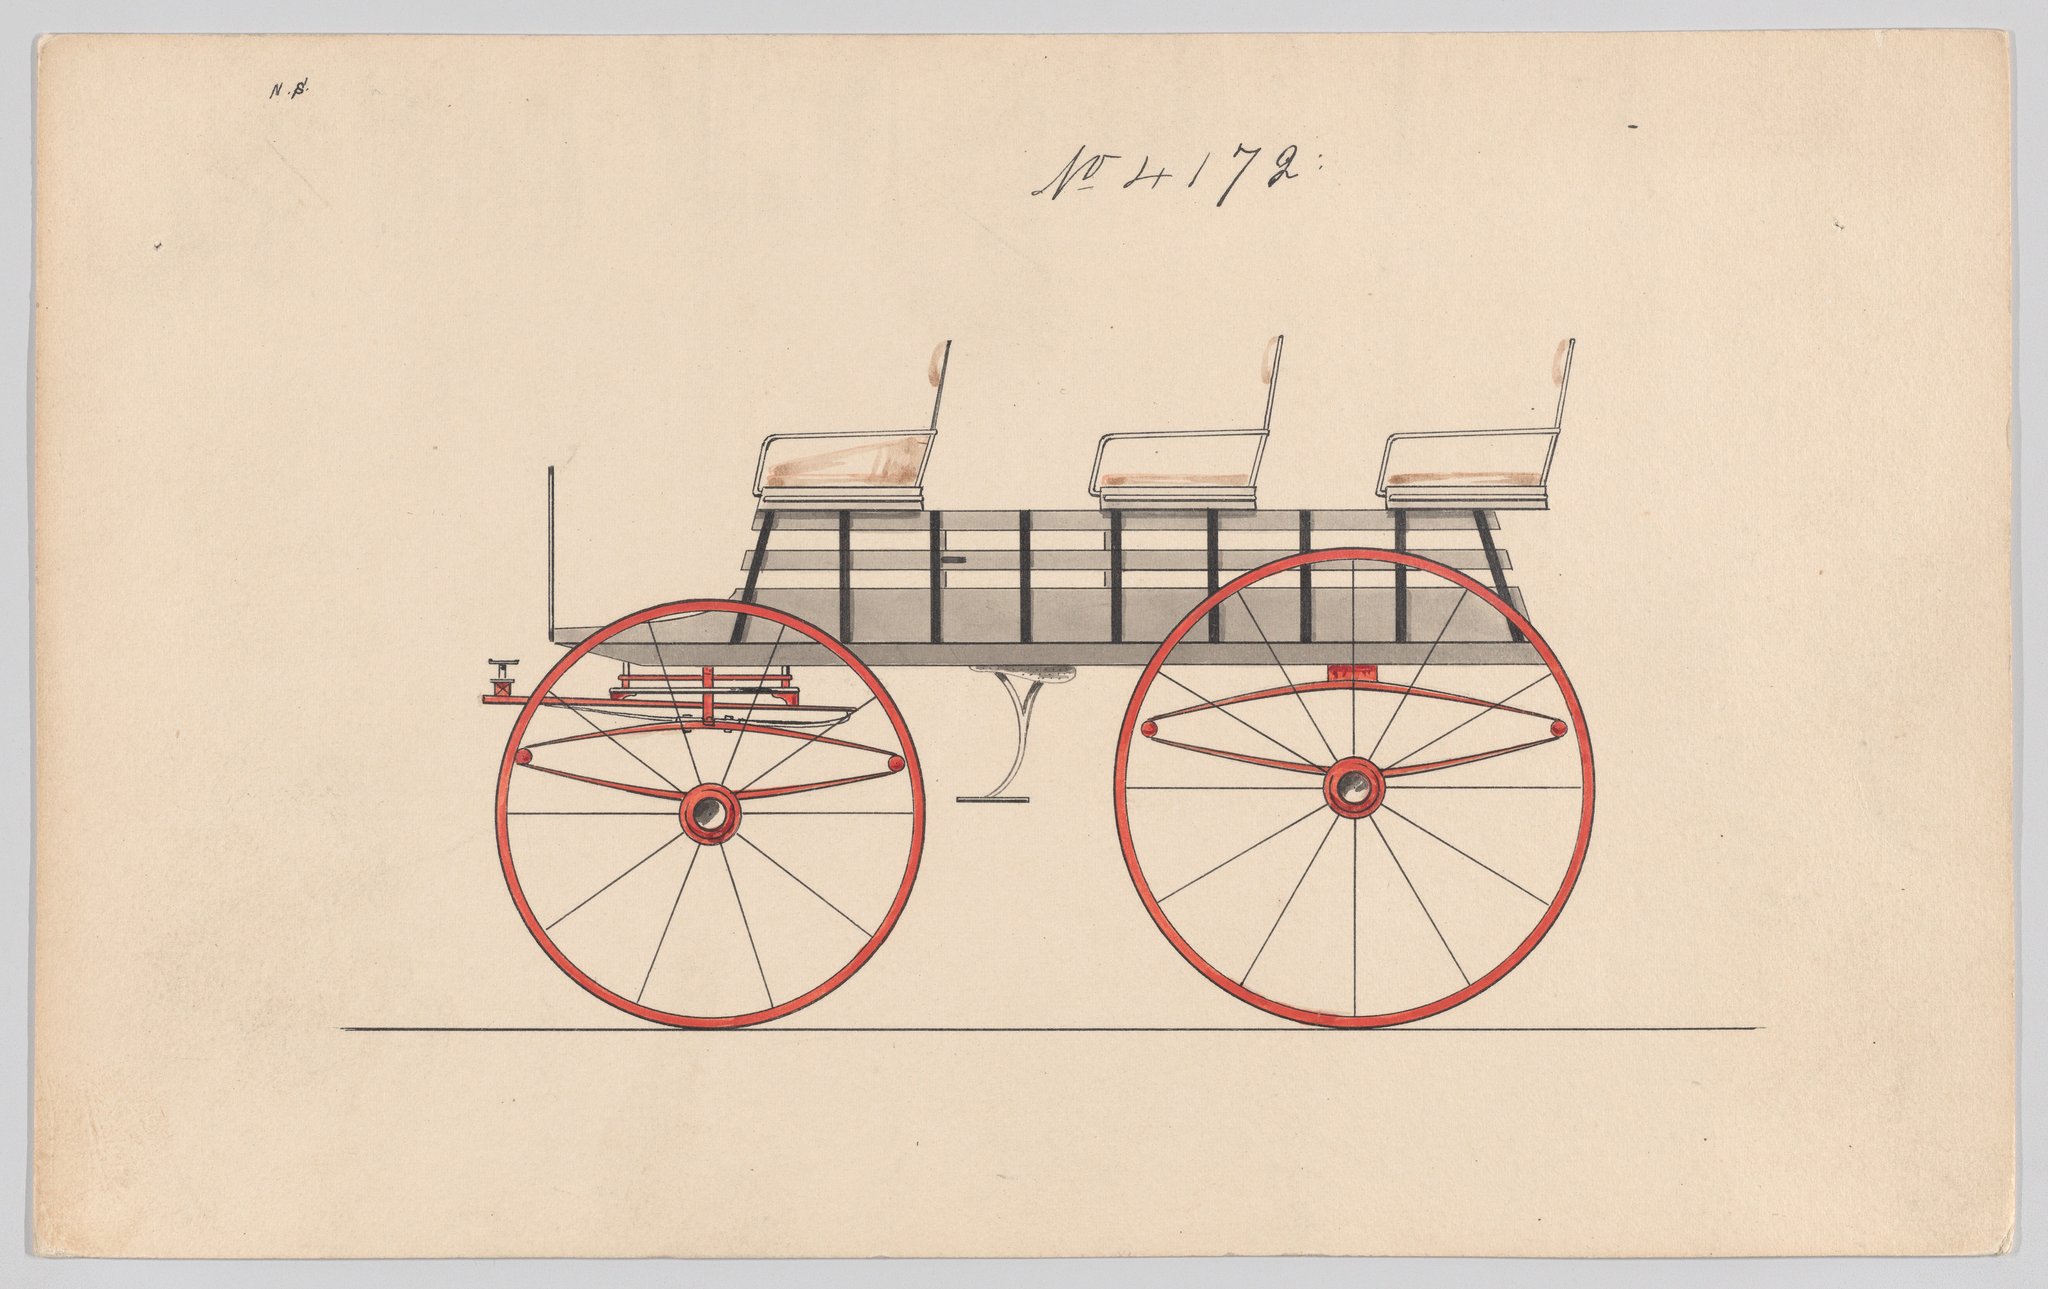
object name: drawing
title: Slat Side Break/Phaeton #4172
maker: brewster & co.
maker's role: manufacturer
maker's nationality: american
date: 1892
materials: gouache, watercolor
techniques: pen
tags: carriages